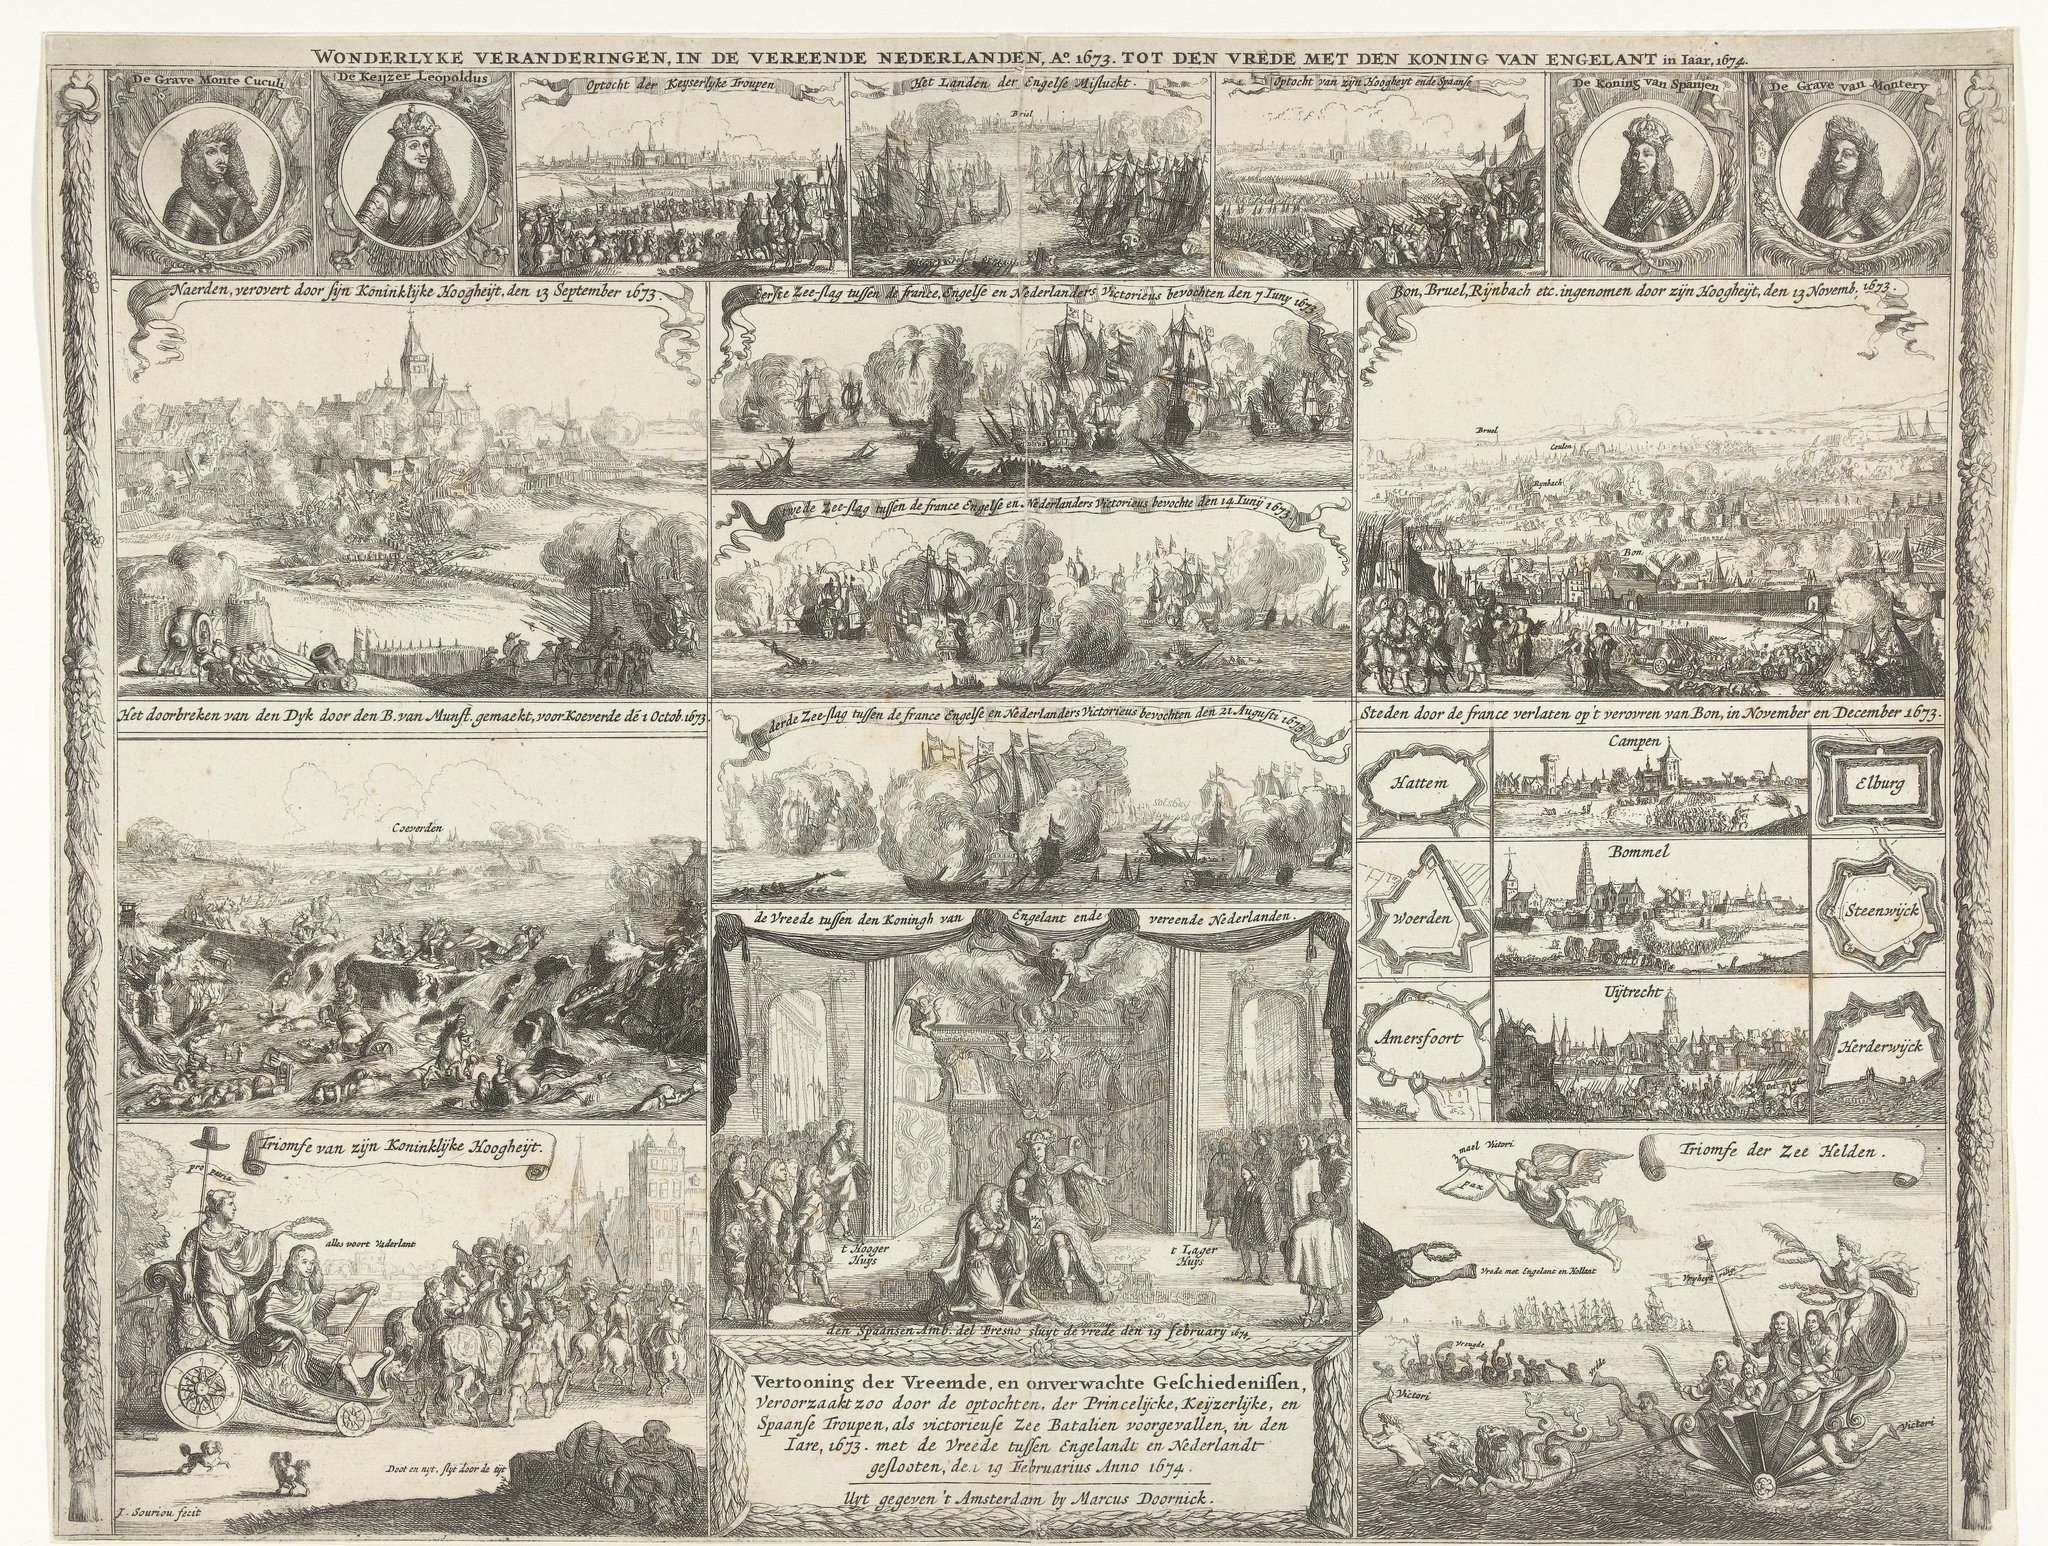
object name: print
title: Drie platen over de gebeurtenissen vanaf 1672 tot aan de vrede in 1674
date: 1674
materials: paper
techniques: etching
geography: amsterdam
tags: flushing, michiel adriaenszoon de ruyter, rotterdam, amsterdam, cornelis tromp, the hague, william iii (prince of orange and king of england, scotland, and ireland), juan domingo méndez de haro y fernández de córdoba, vienna, leopold i (keizer van duitsland), karel ii (koning van spanje), commander-in-chief, admiral (+ naval force), symbolic triumphs of individual persons, signing of peace treaty, concluding the peace, utrecht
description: Blad met een overzicht van de oorlogshandelingen in de jaren 1673 en 1674 leidend tot de Vrede van Westminster met Engeland op 19 februari 1674 waarmee een eind kwam aan de derde Engelse Oorlog. Met vele afzonderlijke voorstellingen van veldslagen, zeeslagen, portretten van de belangrijkste personen, triomfen van prins Willem III en de Nederlandse gezagvoerders ter zee. Centraal onderaan wordt te Westminster de eed op het verdesverdrag afgelegd.